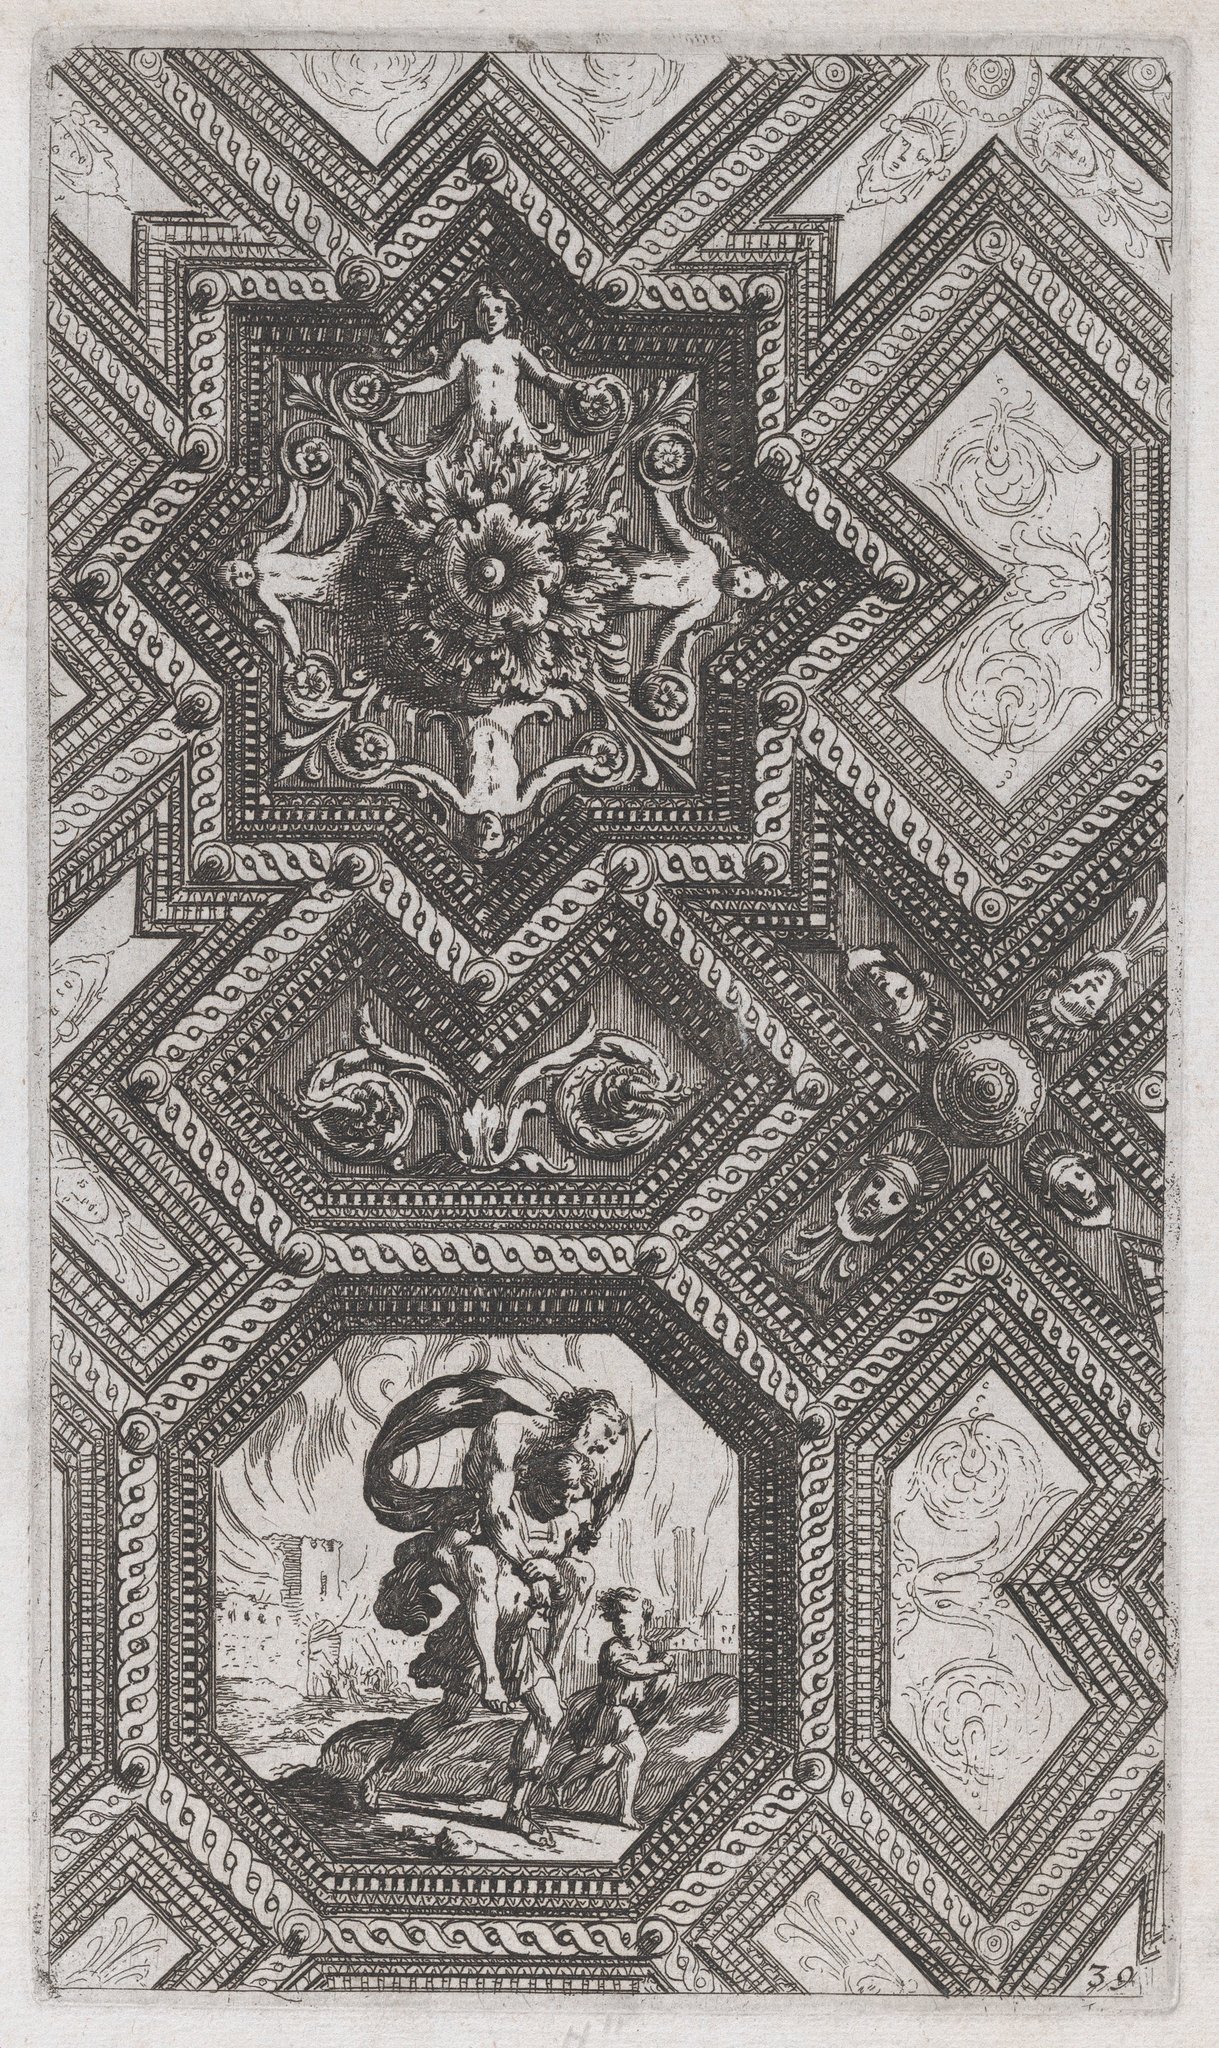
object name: print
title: Ceiling Design, plate 39 from "Curieuses recherches de plusieurs beaus morceaus d'ornemens antiques et modernes..."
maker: jacques lepautre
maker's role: artist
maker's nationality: french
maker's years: 1653-1684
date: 1645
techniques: etching